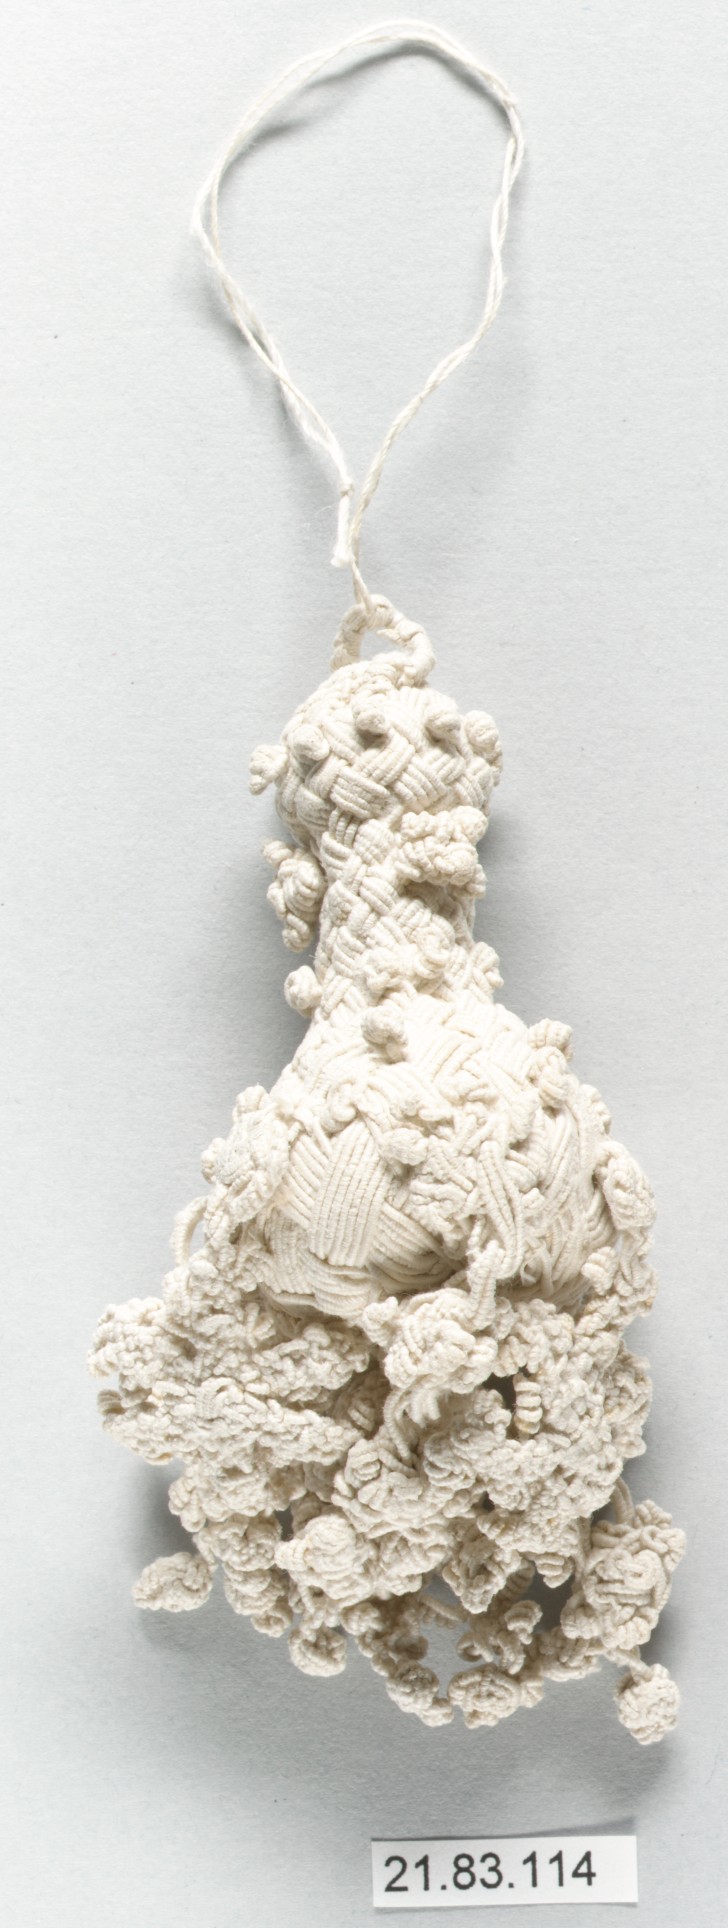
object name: tassel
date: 1601-1700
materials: linen